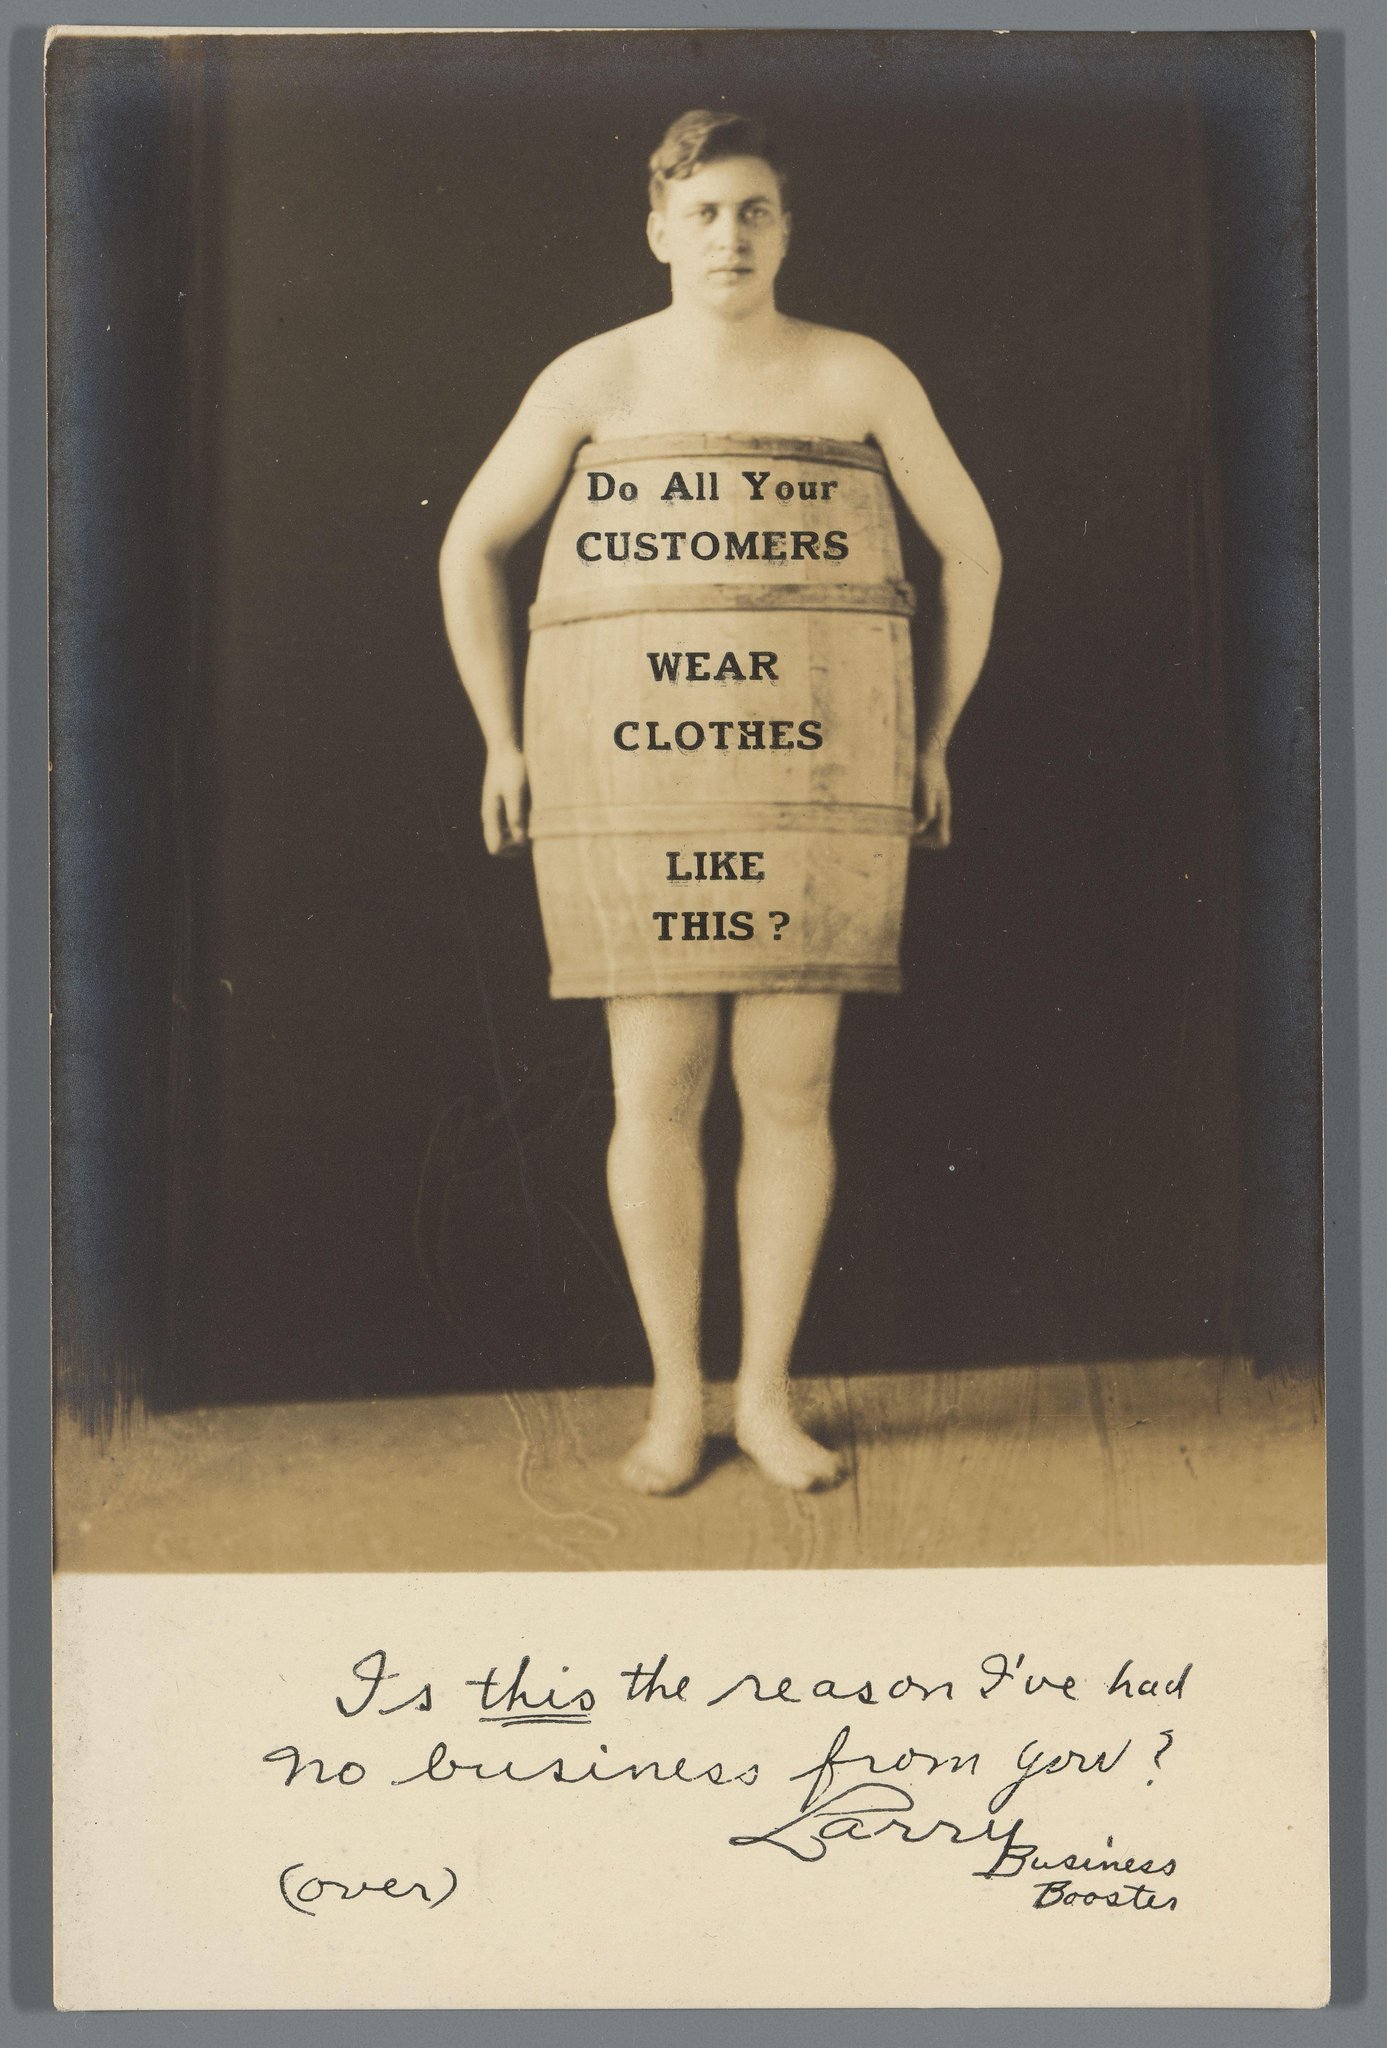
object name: ansichtkaart, prentbriefkaart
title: Reclame voor Kahn Bros, Louisville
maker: Anonymous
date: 1930-1950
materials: photographic support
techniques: gelatin silver print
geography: united states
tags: bedrijf, kahn bros, louisville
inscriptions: inscription, inscription